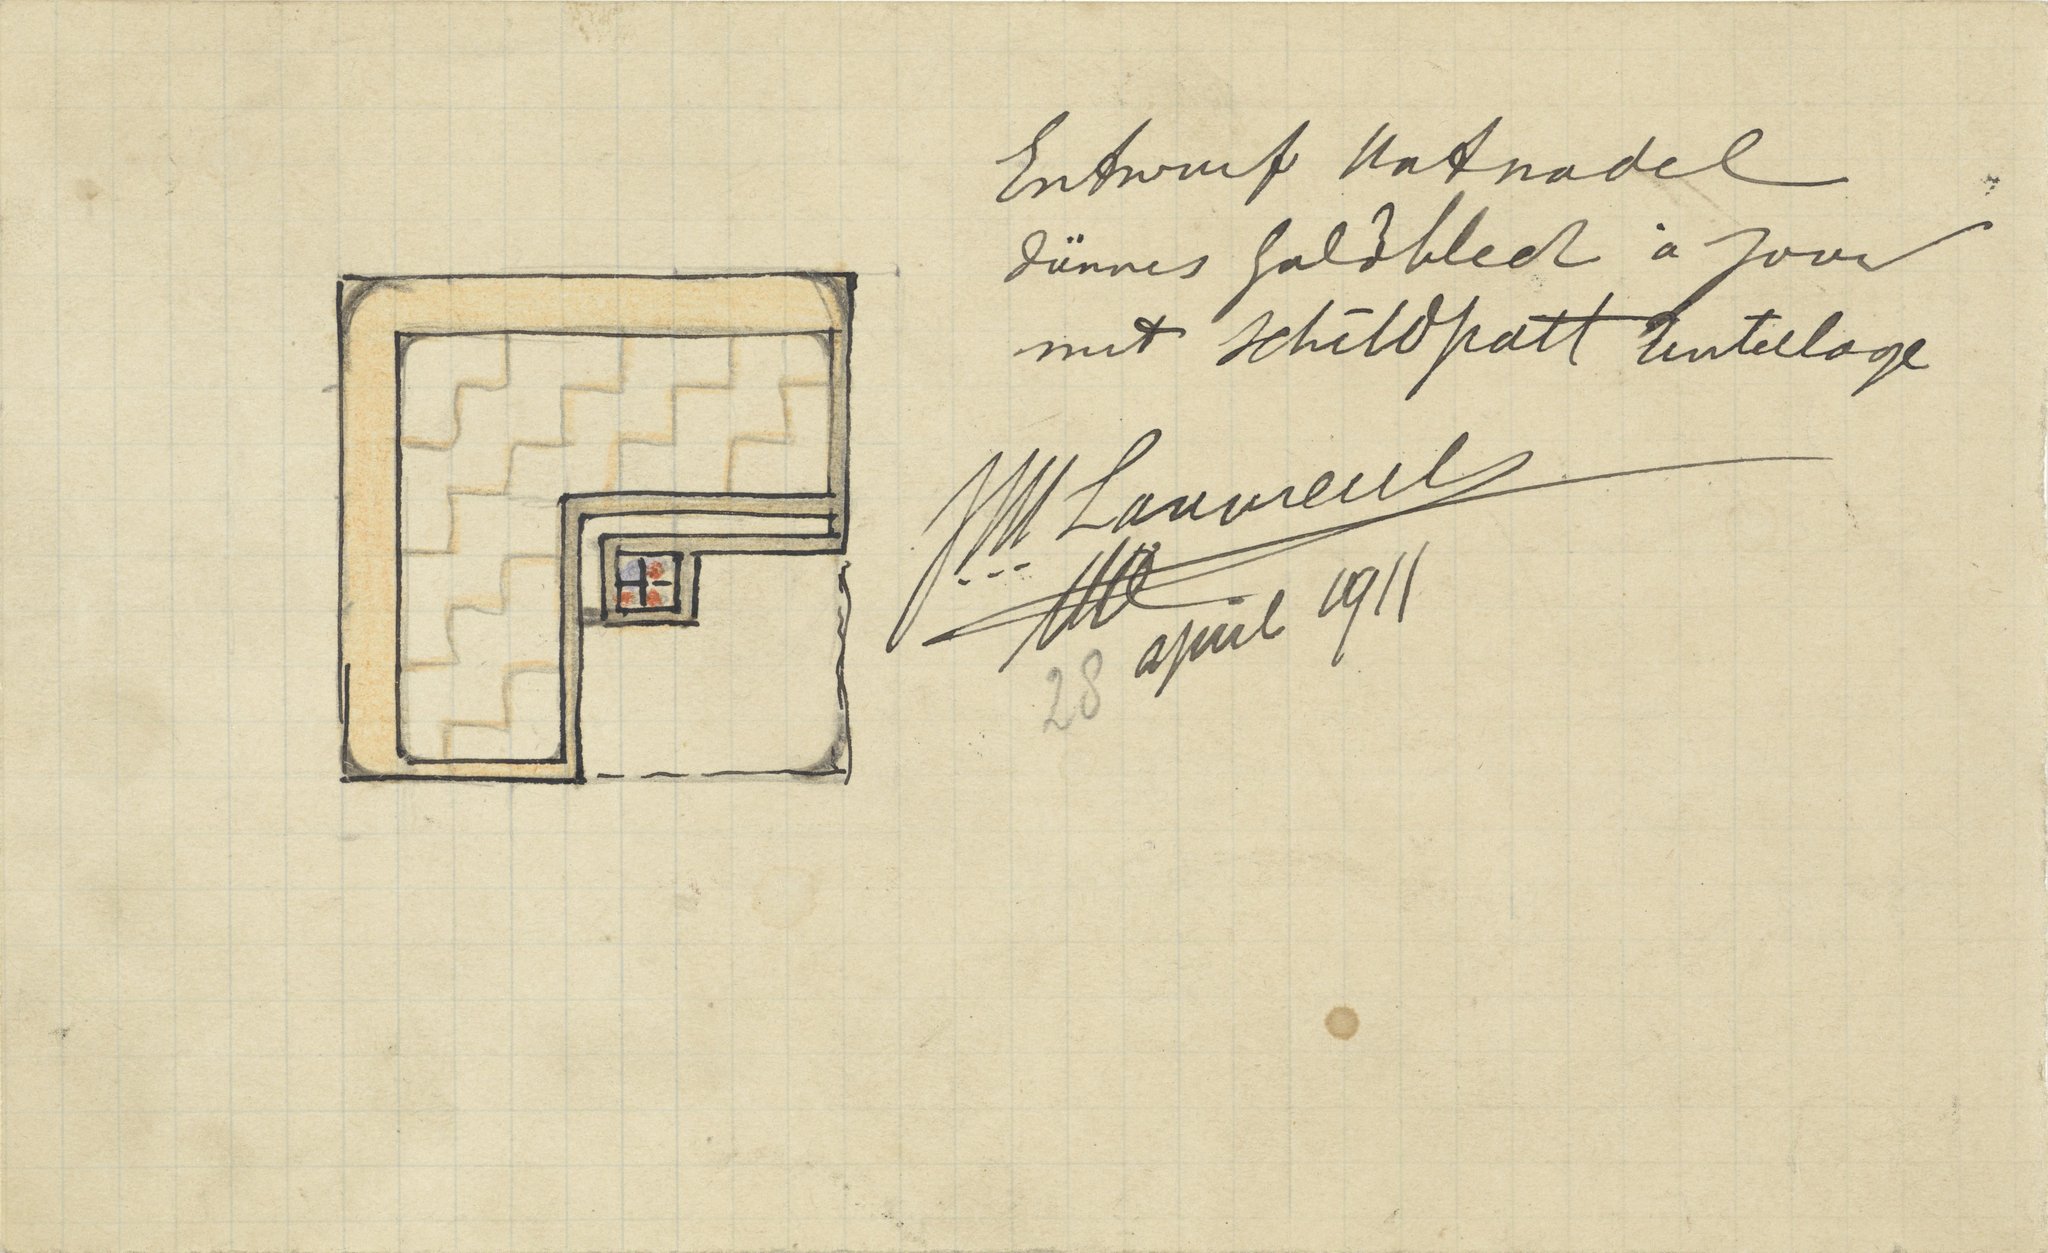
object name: drawing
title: Ontwerp voor een hoedenspeld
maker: mathieu lauweriks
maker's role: designer, draughtsman, print maker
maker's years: 1864-1932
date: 1911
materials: ink, pencil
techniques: pen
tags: ornaments, jewels, pin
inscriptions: date: ‘28 April 1911’